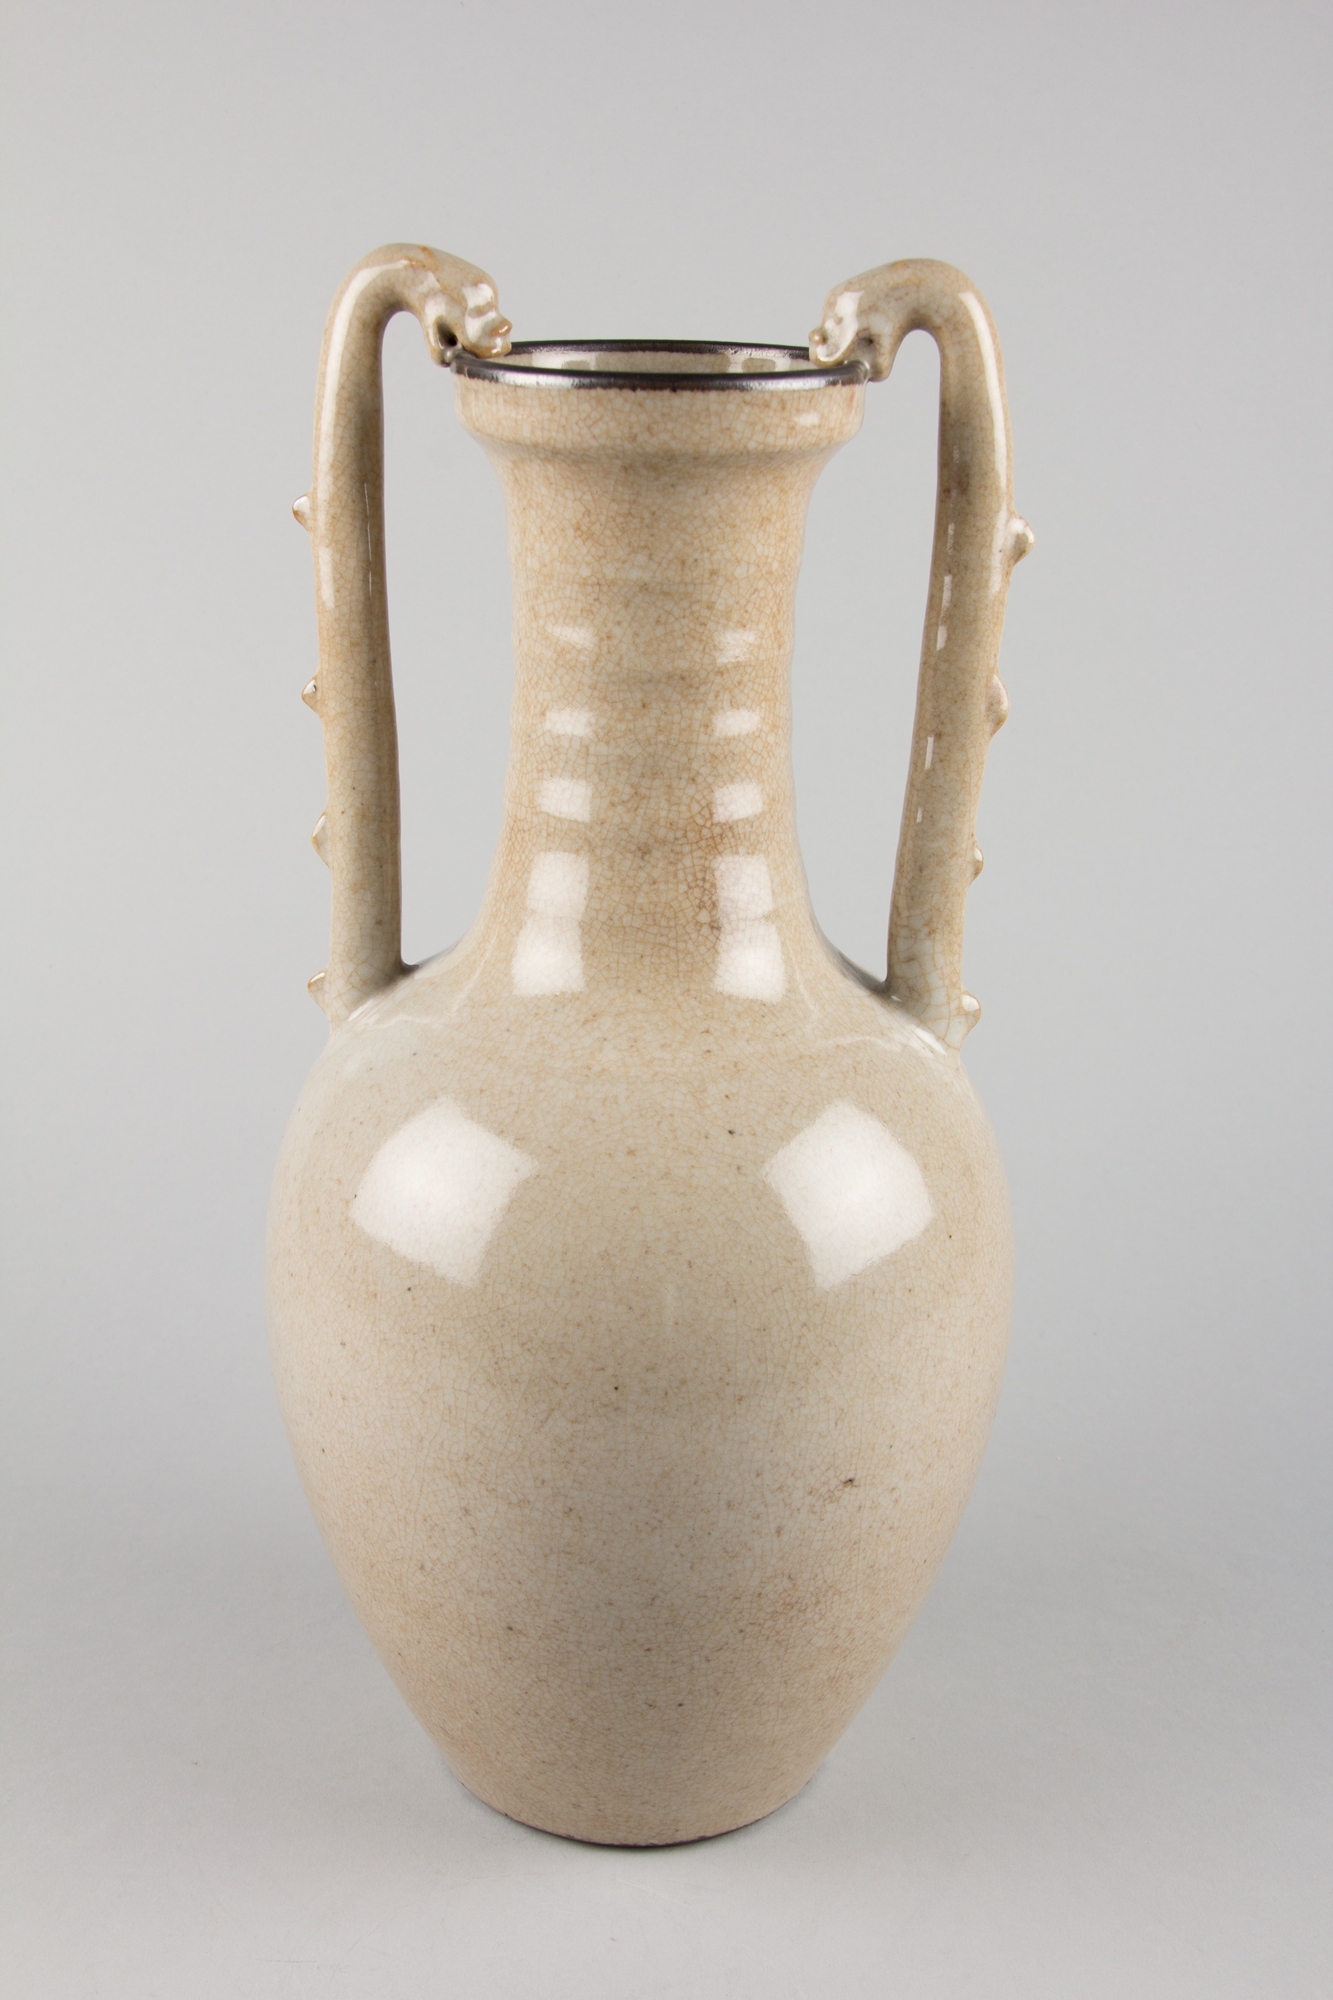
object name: vase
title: Vase with dragon handles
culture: chinese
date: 1701-1800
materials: glaze, porcelain